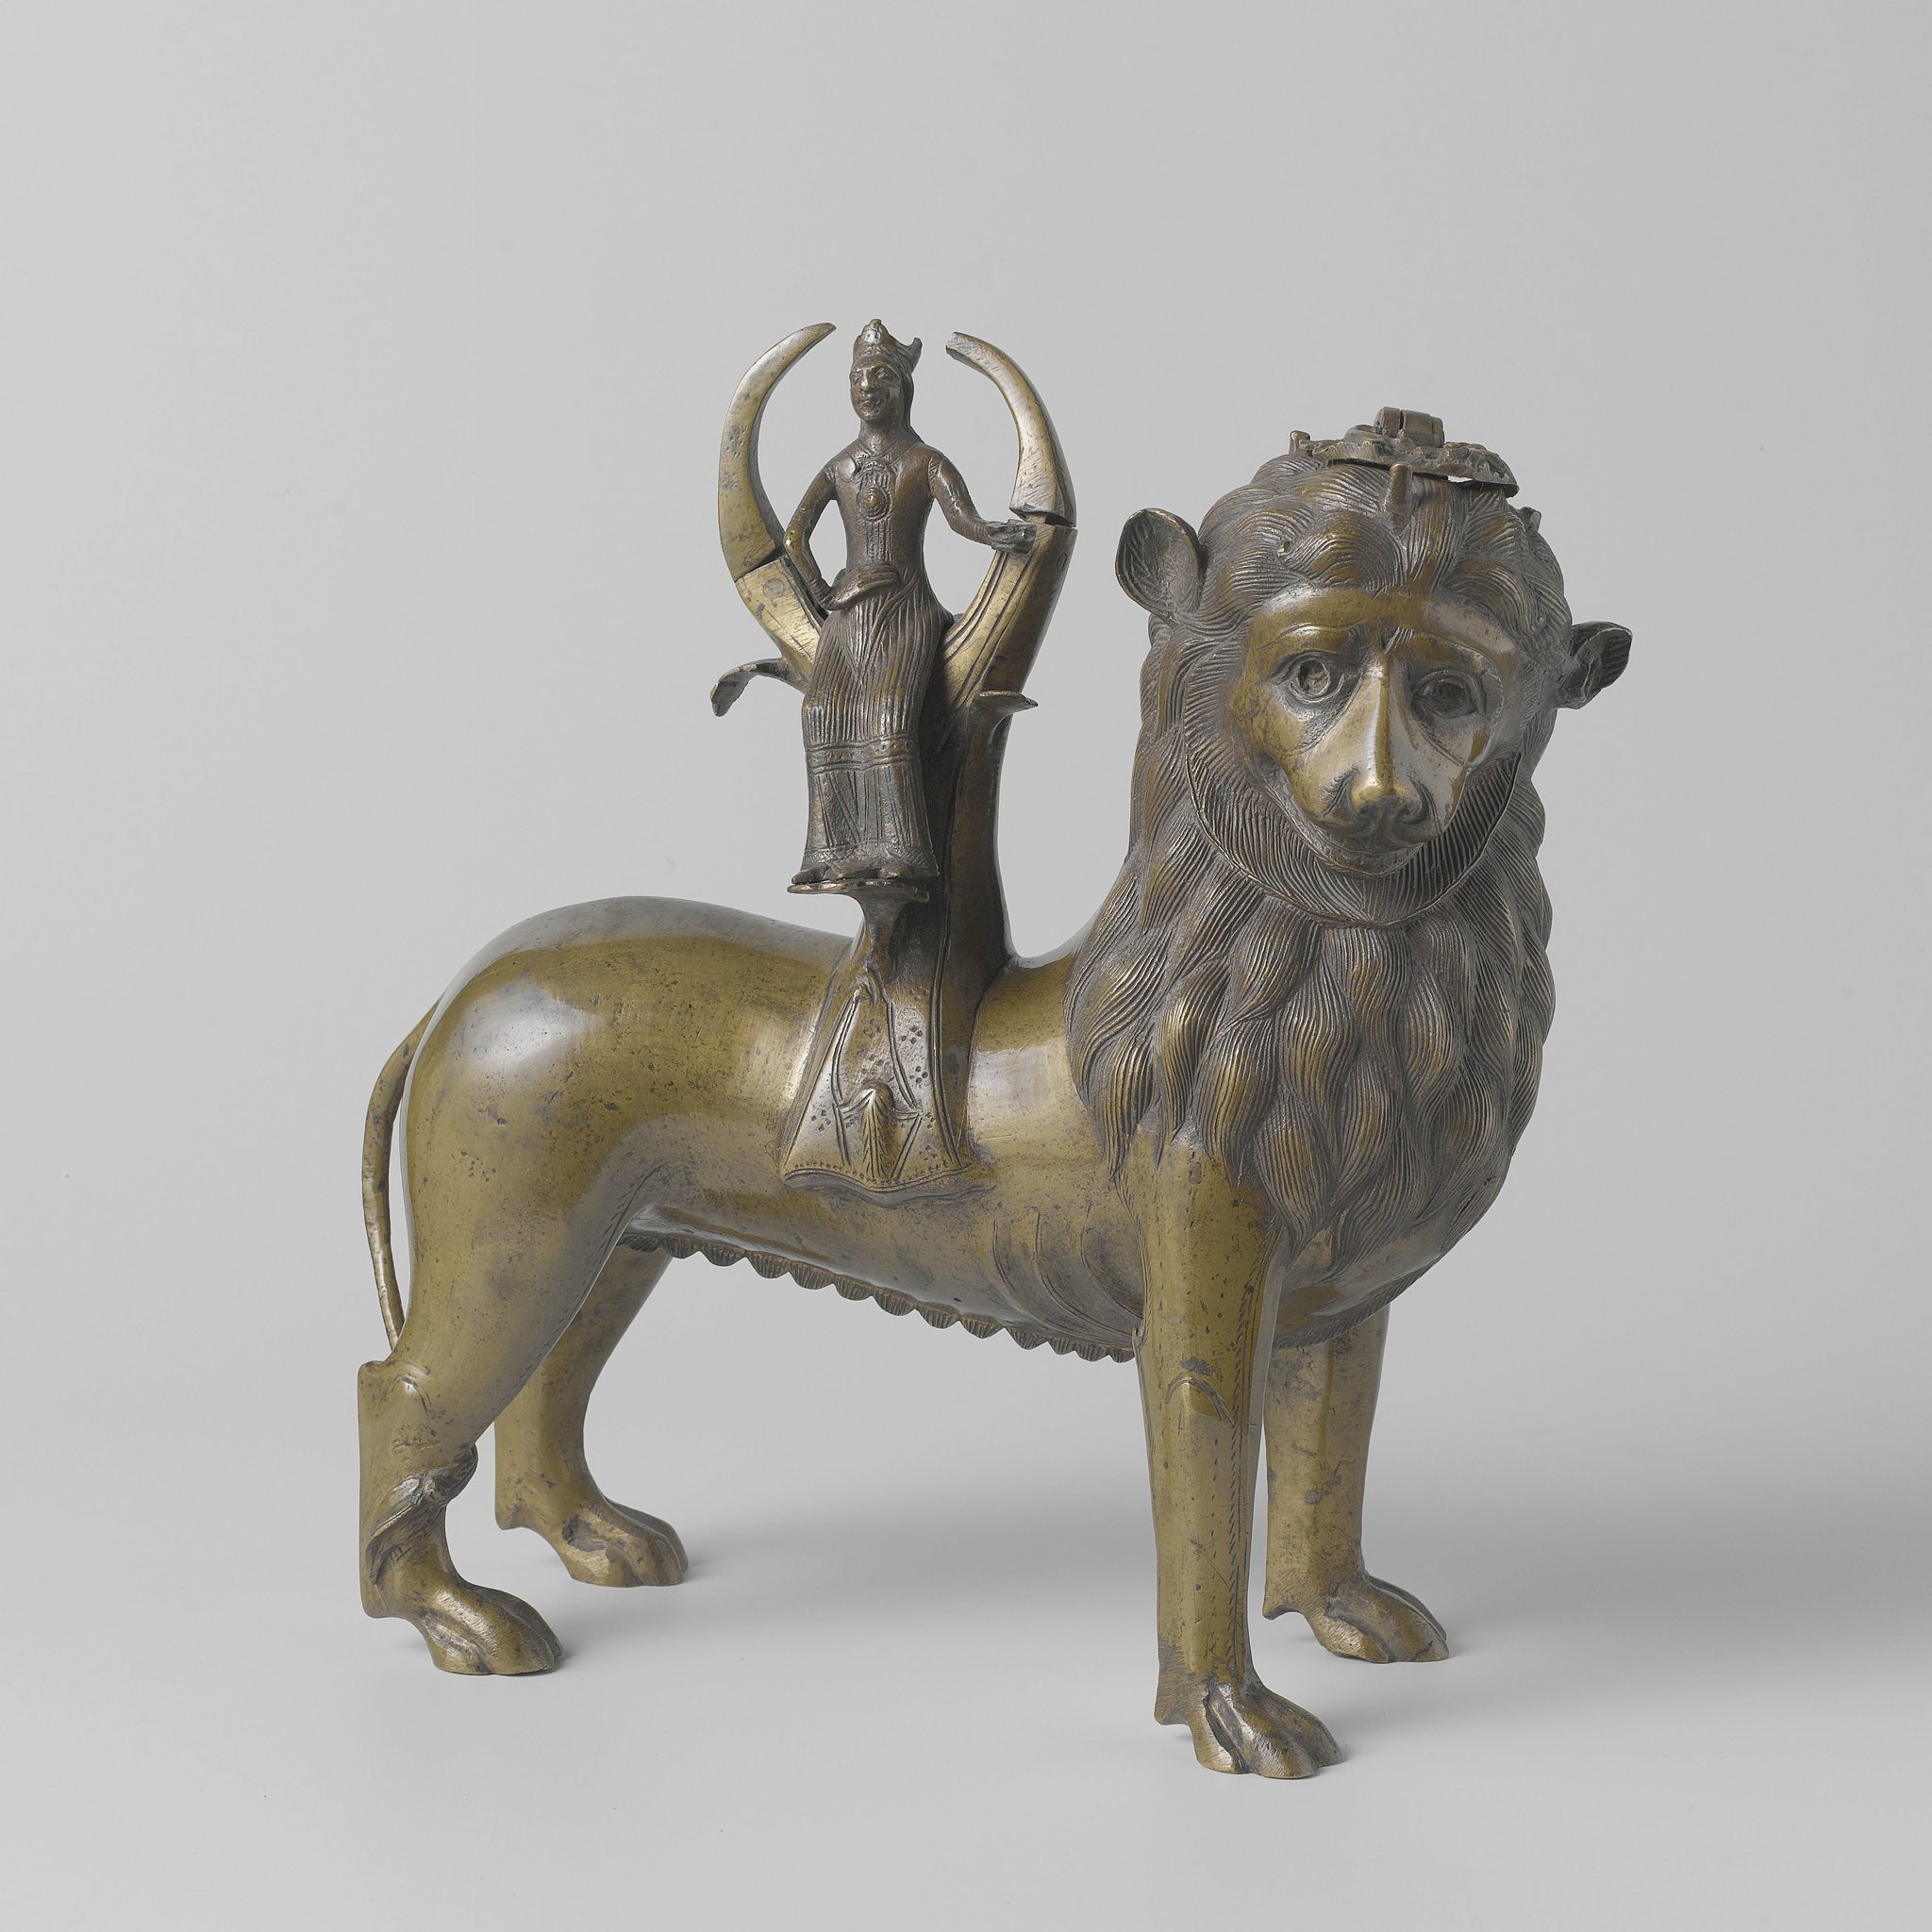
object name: aquamanile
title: Aquamanile in the Form of a Lion with a Mounted Female Figure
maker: Anonymous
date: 1220-1230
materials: copper alloy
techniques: casting, metalworking, engraving, punching, riveted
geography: hildesheim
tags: adult woman, beasts of prey, predatory animals: lion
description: Aquamanile van koperlegering, in de vorm van een leeuw met op zijn rug vrouwenfiguur. Het in cire perdue-techniek gegoten en vervolgens bijgeciseleerde voorwerp, waarvan details zijn uitgestoken, gegraveerd en geponst, heeft de vorm van een leeuw, die zijn kop schuin naar rechts heeft gewend en de staart om zijn rechter achterpoot heeft geslagen. Op zijn rug een gaffelvormige boom met vier uitstekende bladeren. Op twee van die bladeren is een gekroonde vrouwenfiguur geklonken. Zij is gekleed in een lang gewaad en draagt een juweel op de borst. Haar rechterhand houdt zij op de buik, met haar linker opzij gestrekte hand heeft zij oorspronkelijk iets vastgehouden. De leeuw heeft een grijnzende kop omgeven door een ringbaard en met afstaande oren, waarvan er één als tuit dienst doet. Op de kop bevinden zich drie uitsteeksels en daartussen een door een scharnier bevestigde klep, die met rococo-ornament is versierd. De klep dekt het gat af, waardoor het als kan dienst doende voorwerp met water kon worden gevuld. Kop, hals en borst zijn voorzien van stevige lokken. Een gekarteld en gearceerd kielprofiel loopt van borst naar achterpoten. Het gat op de borst tussen de lokken is na verwijdering van de gietkern dichtgemaakt. De geklonken gaffelpunten zitten iets los, de rechter is niet origineel. Eén van de nagels, waarmee de vrouw op de gaffelboom is geklonken, is van ijzer. De klep op de kop van de leeuw dateert uit het midden van de achttiende eeuw. Het scharnier is hersteld met een stuk van rood koper. De loodvullingen in ogen en tuitoor zijn in 1982 verwijderd.